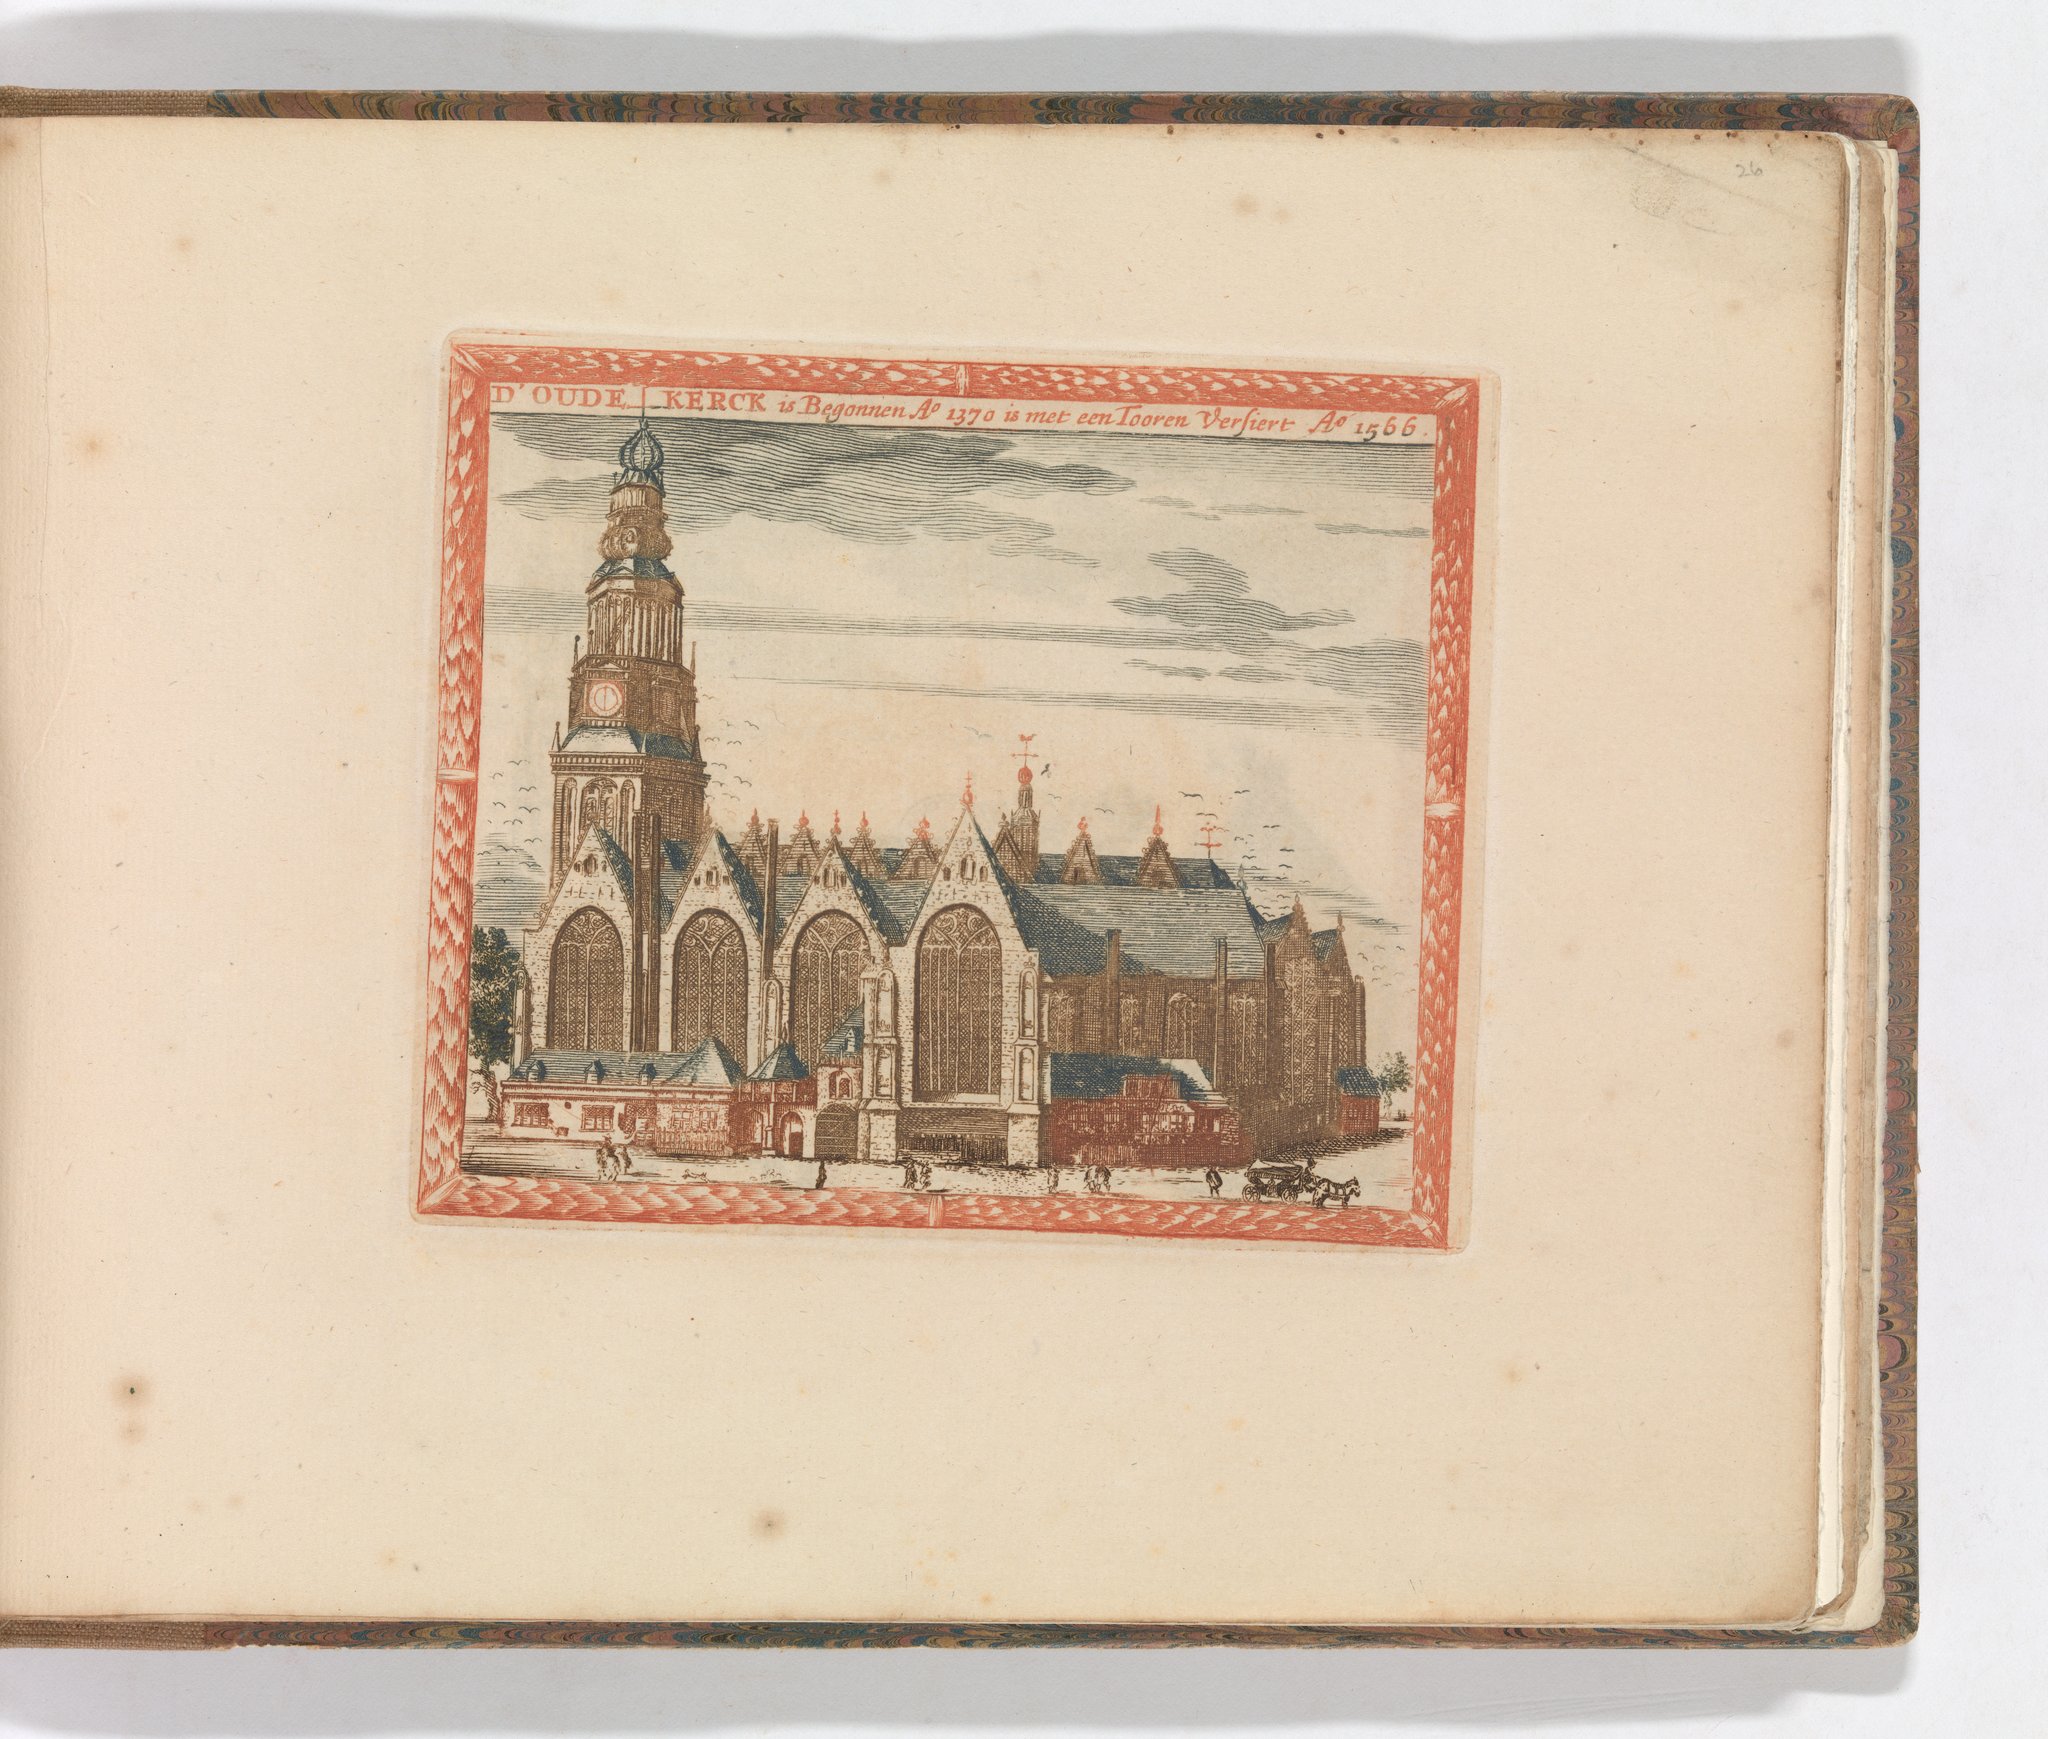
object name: book print ornament architecture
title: 'D' Oude Kerck', in: Tooneel Der Voornaamste Nederlands Huizen, En Lust Hoven, Naar T Leven Afgebeeld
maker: carel allard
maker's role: publisher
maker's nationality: dutch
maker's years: 1648-1709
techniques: engraving, lithography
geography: amsterdam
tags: churches